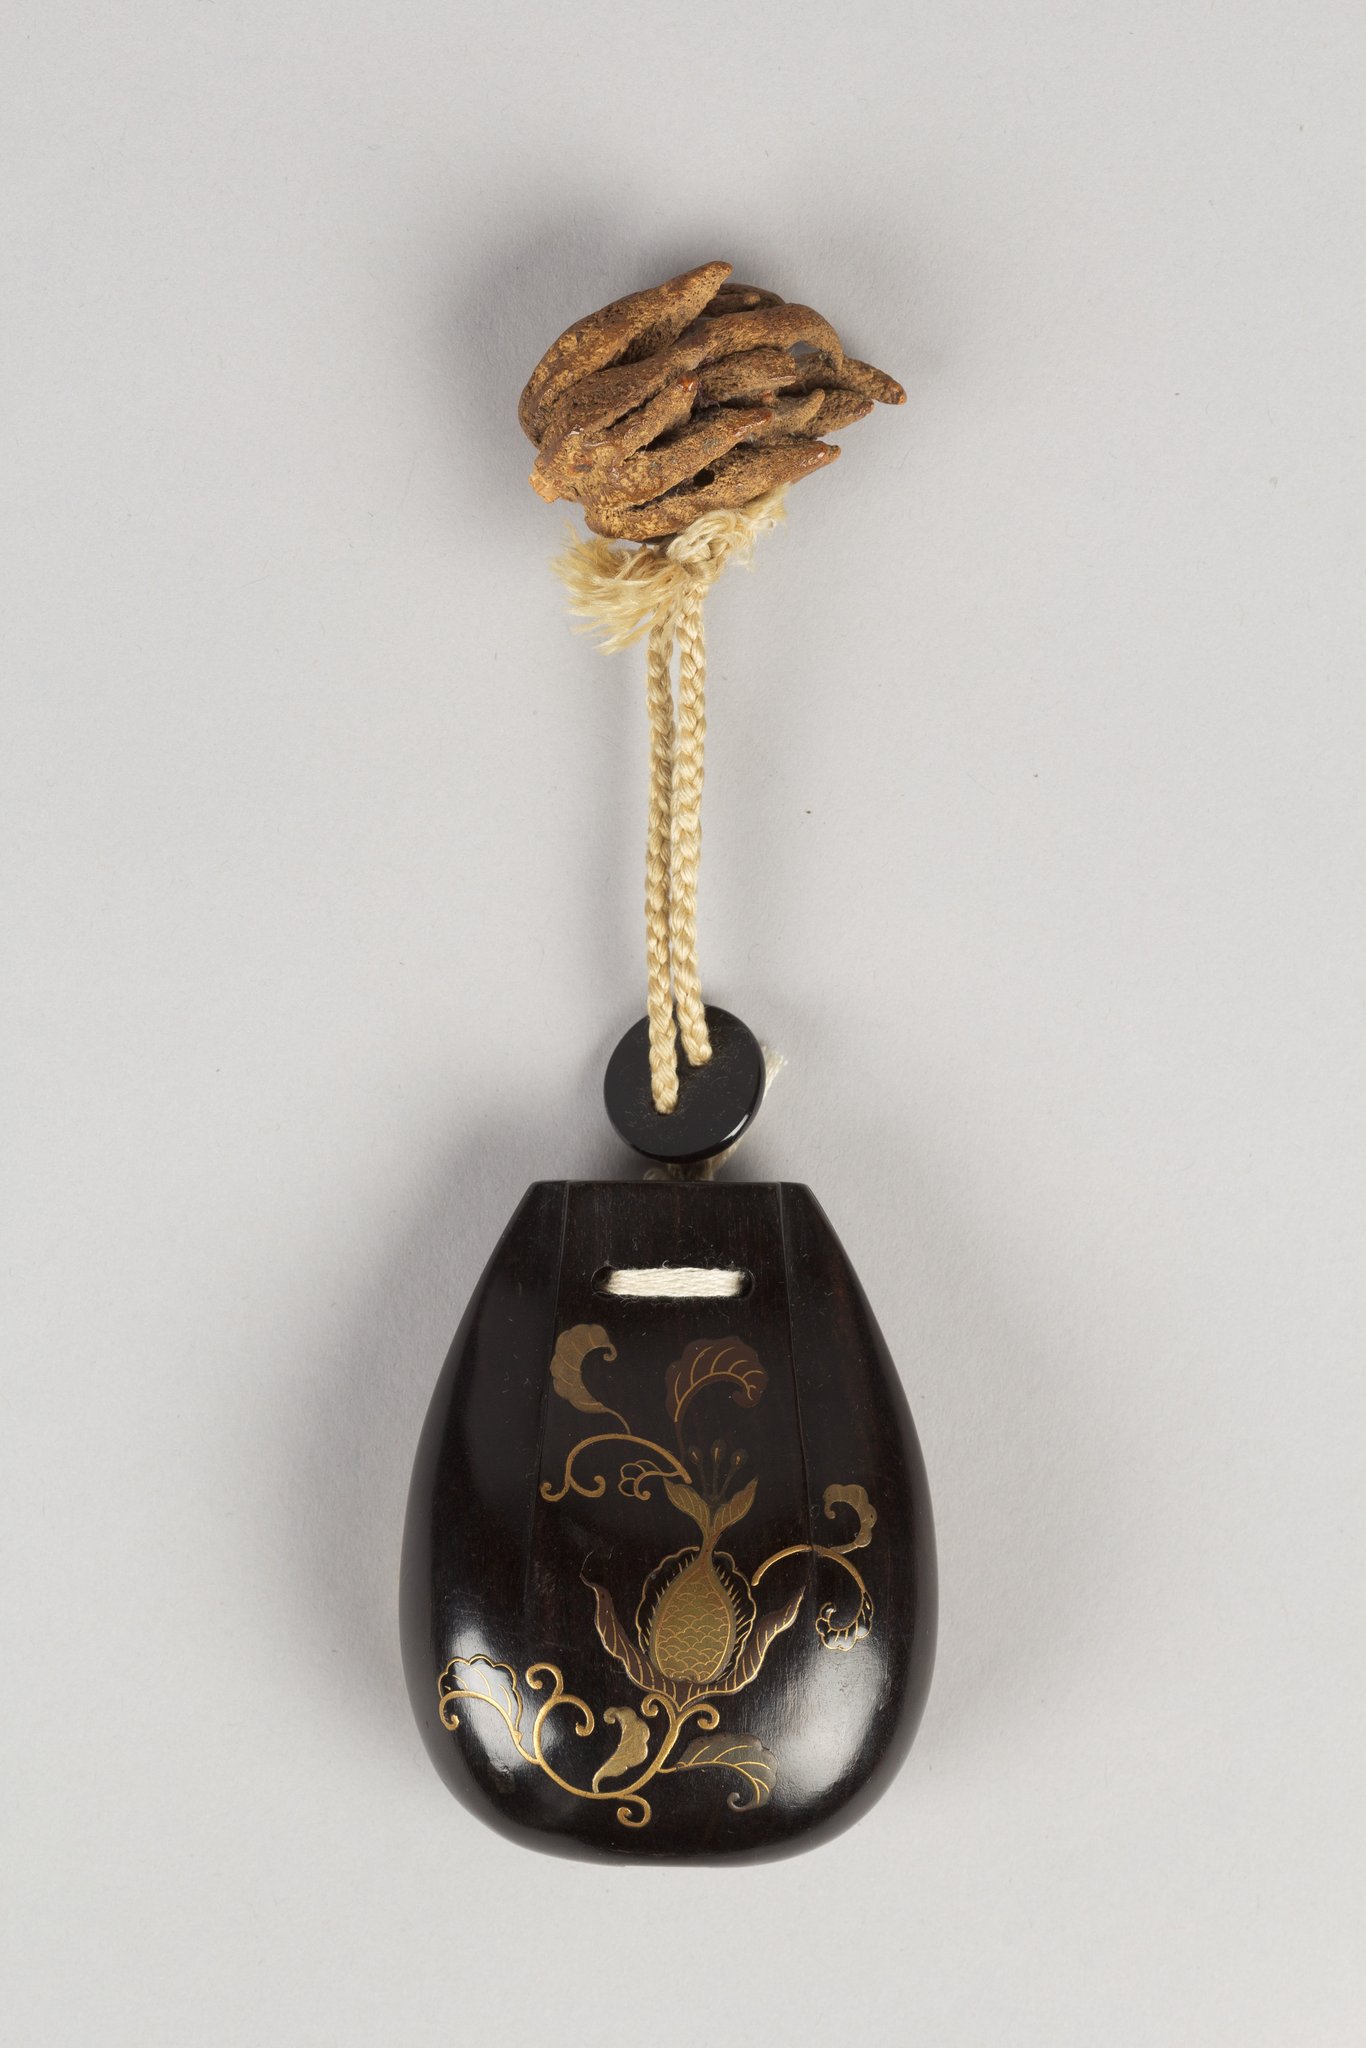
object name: inrō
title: Case (Inrō) with Design of Nanban Flowers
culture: japanese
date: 1801-1900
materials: gold, ivory, lacquer, silver, wood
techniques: maki-e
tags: flowers